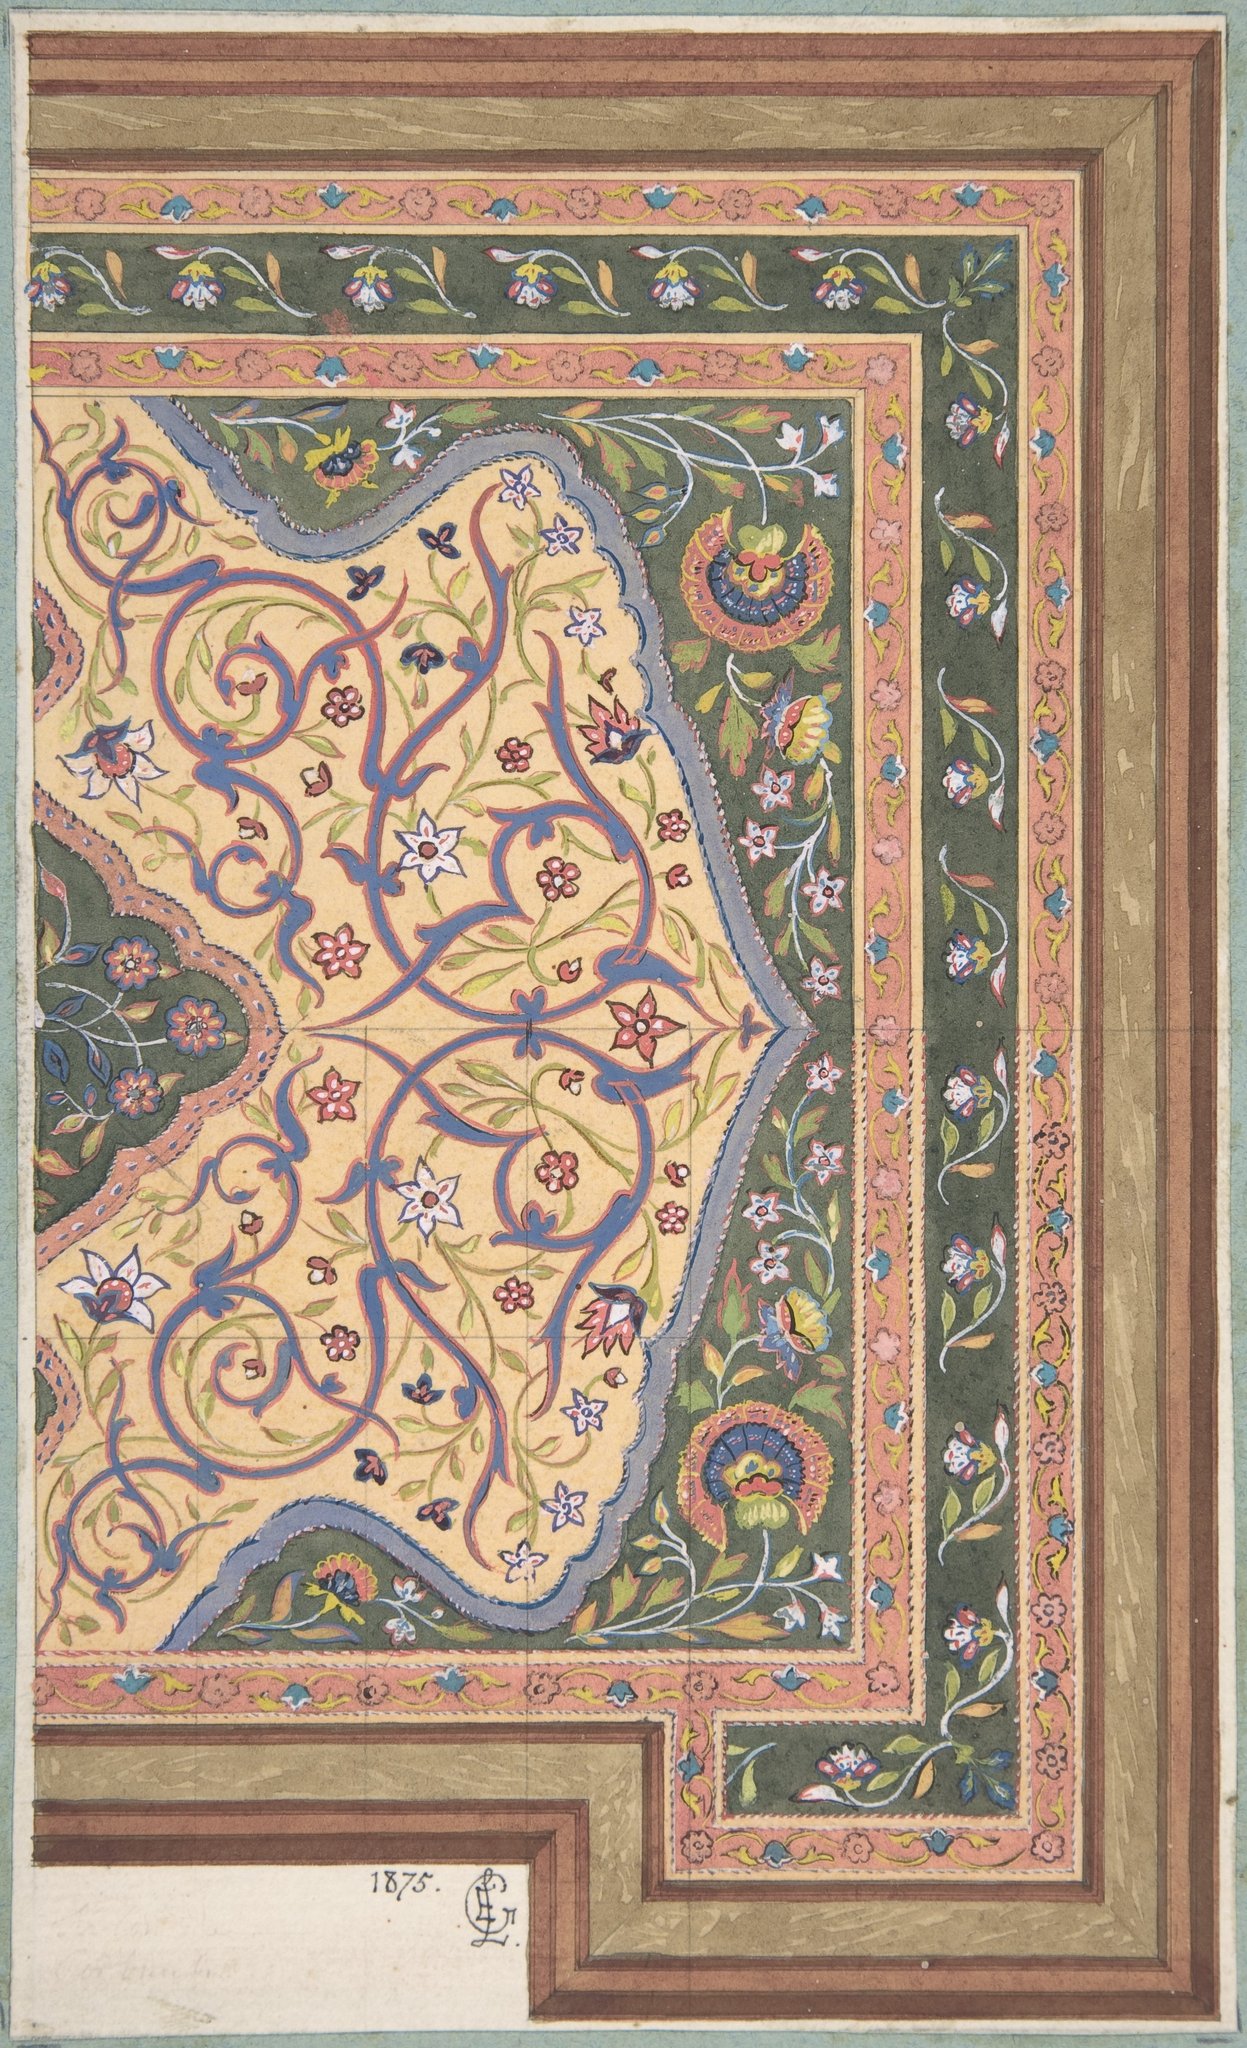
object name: drawing ornament architecture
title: Islamic Ceiling Design for Deepdene, Dorking, Surrey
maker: jules-edmond-charles lachaise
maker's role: artist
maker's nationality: french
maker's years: 1897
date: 1875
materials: gouache, graphite, ink, watercolor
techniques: pen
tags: flowers,ceilings